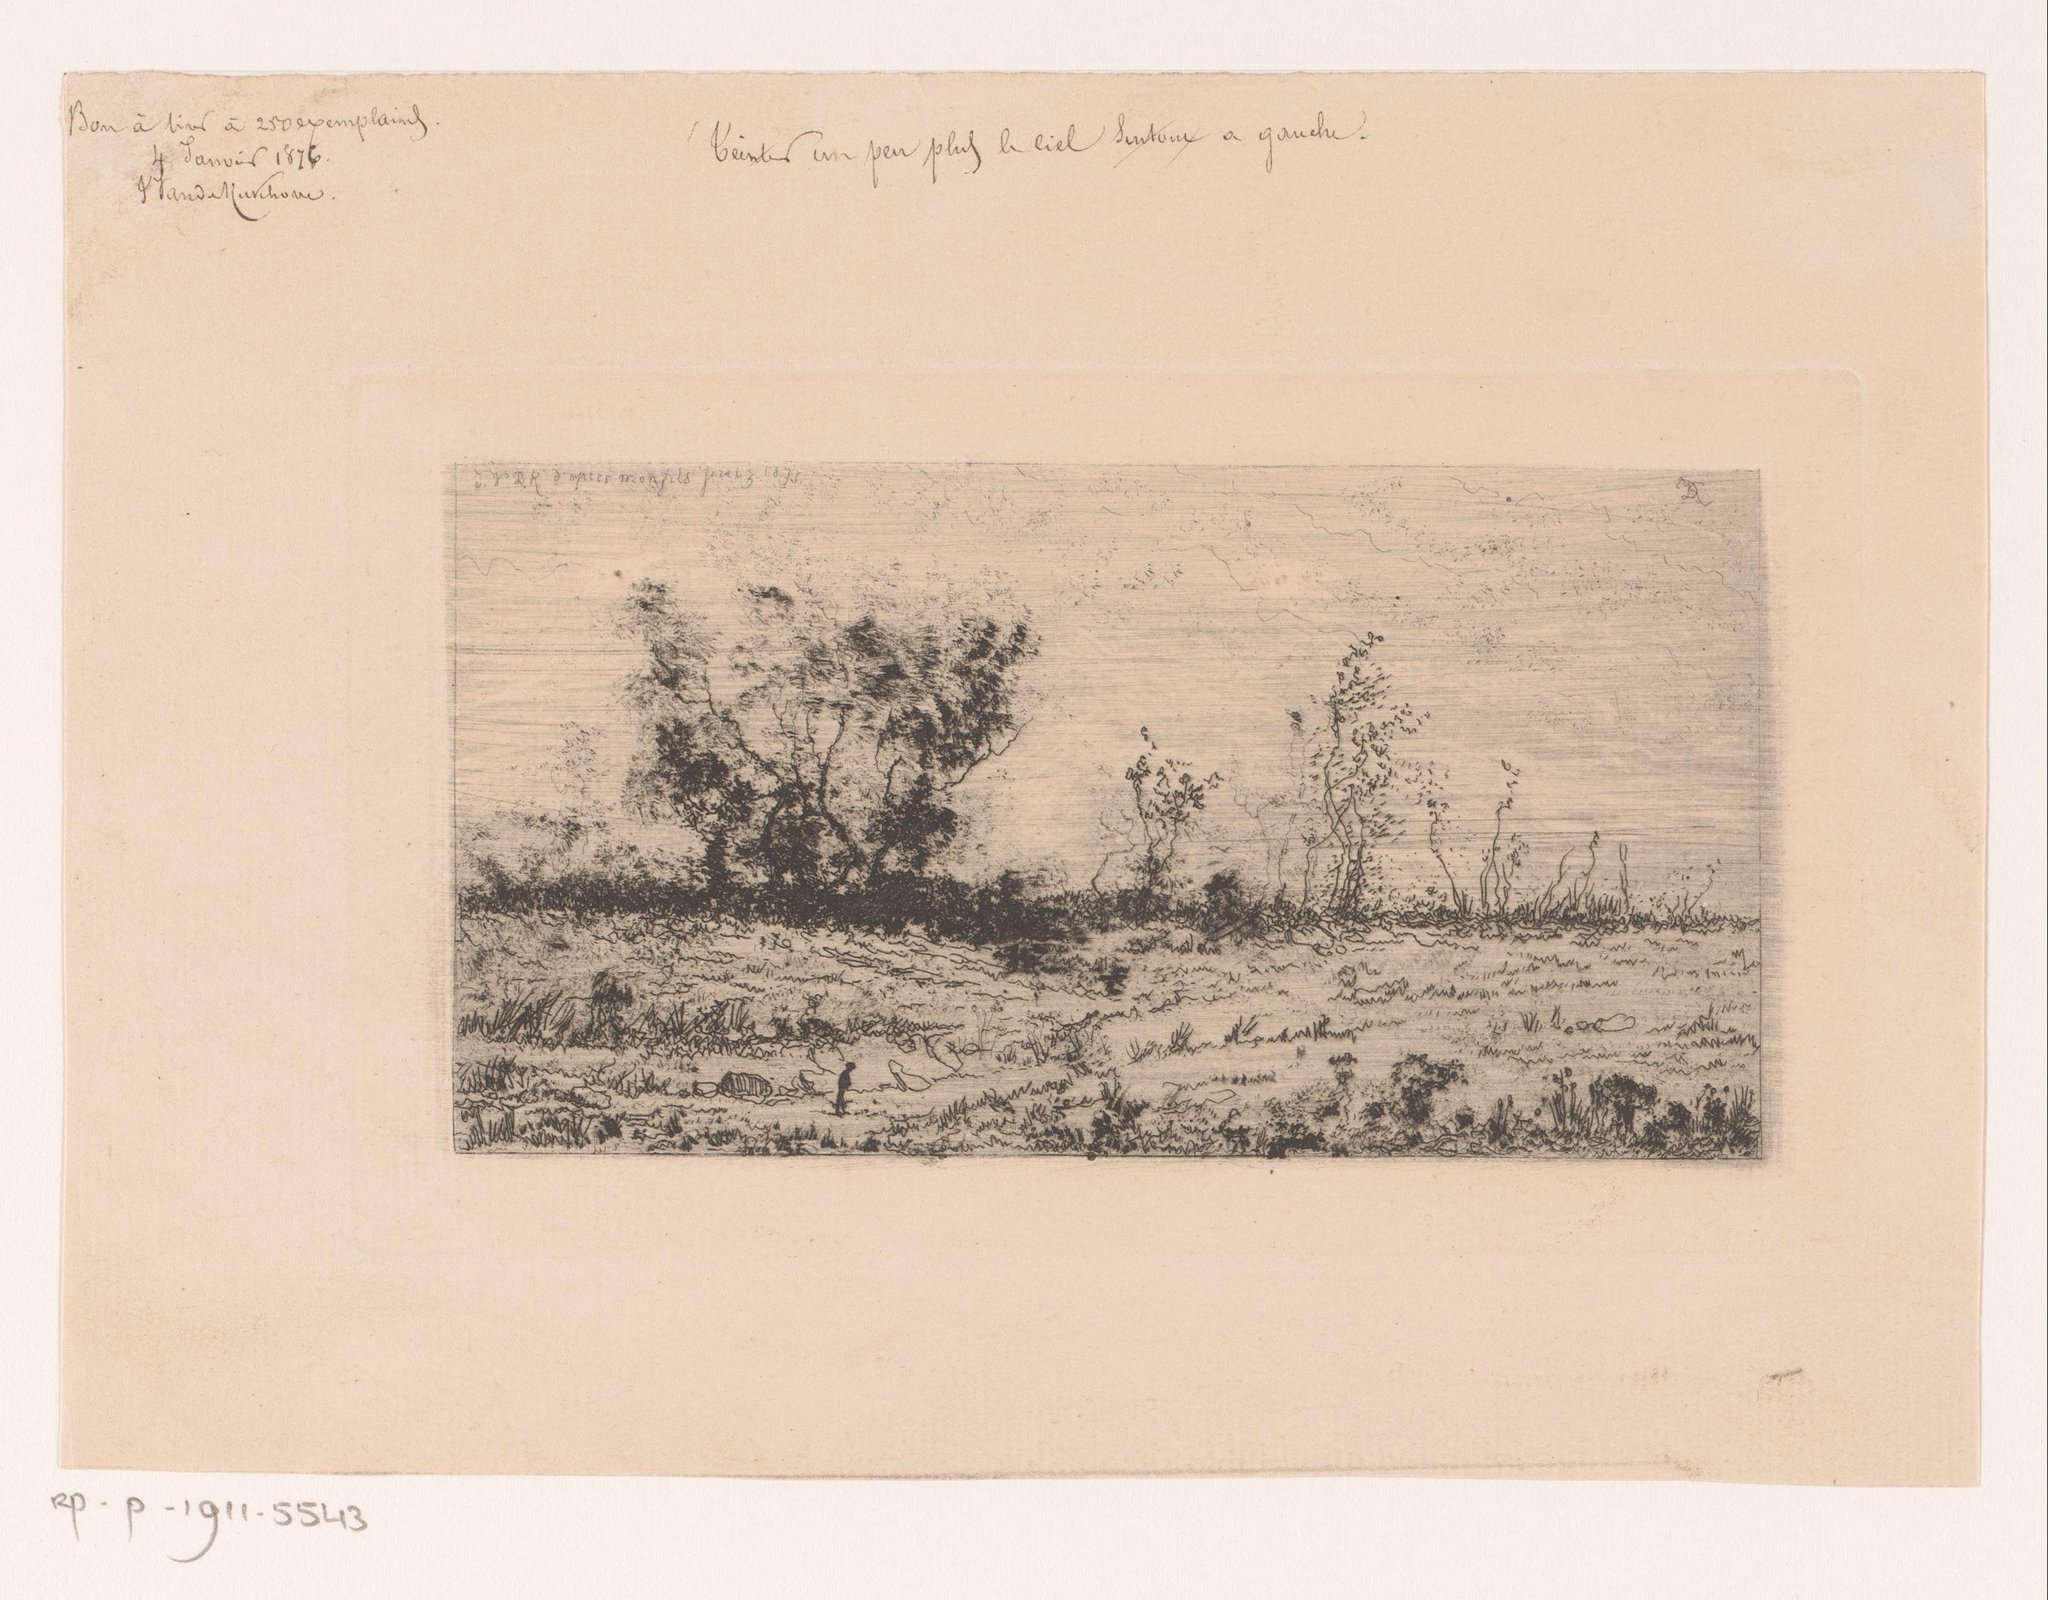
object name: print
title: Landschap met een wandelaar en enkele bomen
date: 1876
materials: paper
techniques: drypoint, etching, intaglio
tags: landscapes in the temperate zone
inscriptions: collector's mark: Lugt 2228, annotation: ‘Bon à tirer à 250 exemplaires. 4 Janvier 1876.’, annotation: ‘Teinter un peu plus la ciel surtout a gauche.’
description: De etsen naar de schilderijen van Frédéric Van de Kerkhove werden na zijn dood door zijn vader en zuster gemaakt en uitgegeven in twee reeksen. De eerste werd in 1877 uitgegeven door het Journal des Beaux-Arts et de la Littérature: Cahier de 25 Eaux-fortes d'après Frédéric van de Kerkhove, gravées par son père et sa sœur. De tweede reeks van 126 etsen, ook in 1877, werd in Parijs uitgegeven bij A. Lévy onder de titel Cent eaux-fortes gravées par J. Van de Kerkhove d'après les tableaux de Frédéric Van de Kerkhove, mort en 1873 à l'âge de 10 ans et 11 mois.